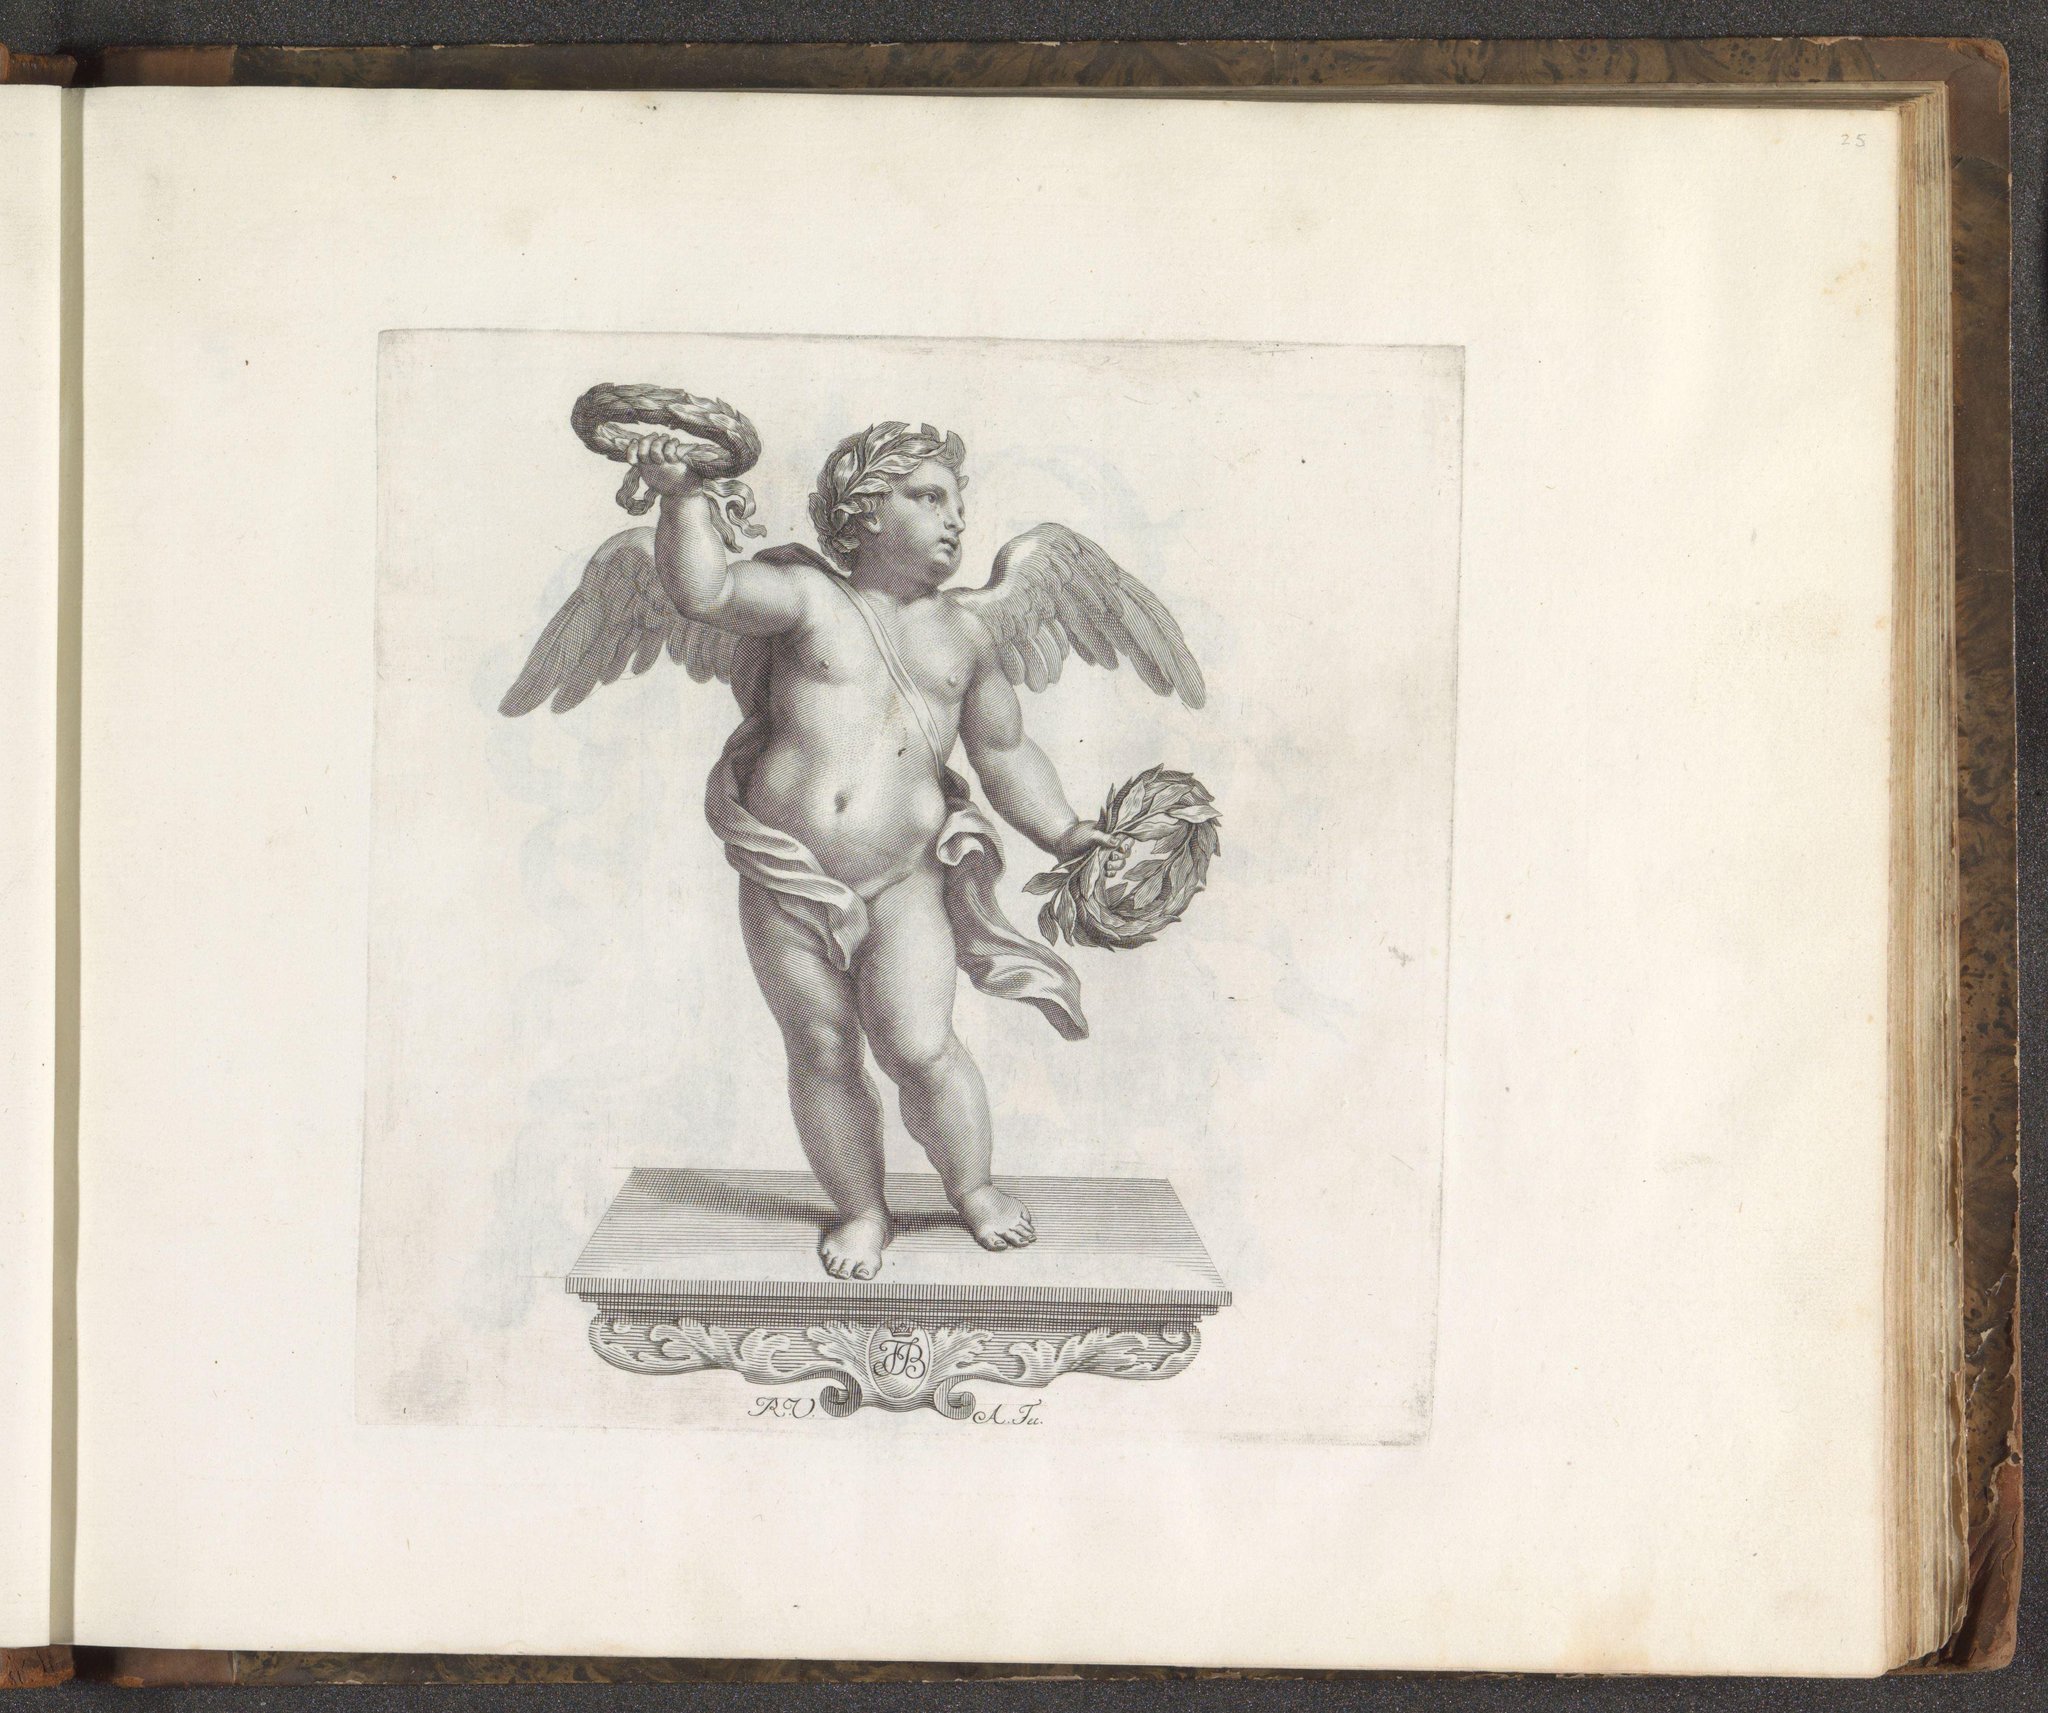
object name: print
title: Liefde brengt Deugd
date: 1673-1743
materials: paper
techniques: engraving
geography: rome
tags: garland, wreath, virtuousness; 'amor di virtù', 'attione virtuosa', 'guida sicura de' veri honori', 'virtù', 'virtù insuperabile' (ripa), angel(s) represented as child(ren)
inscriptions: collector's mark: Lugt 2228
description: Een console met een engel. In zijn handen heeft hij twee lauwerkransen. De prent maakt deel uit van een album.